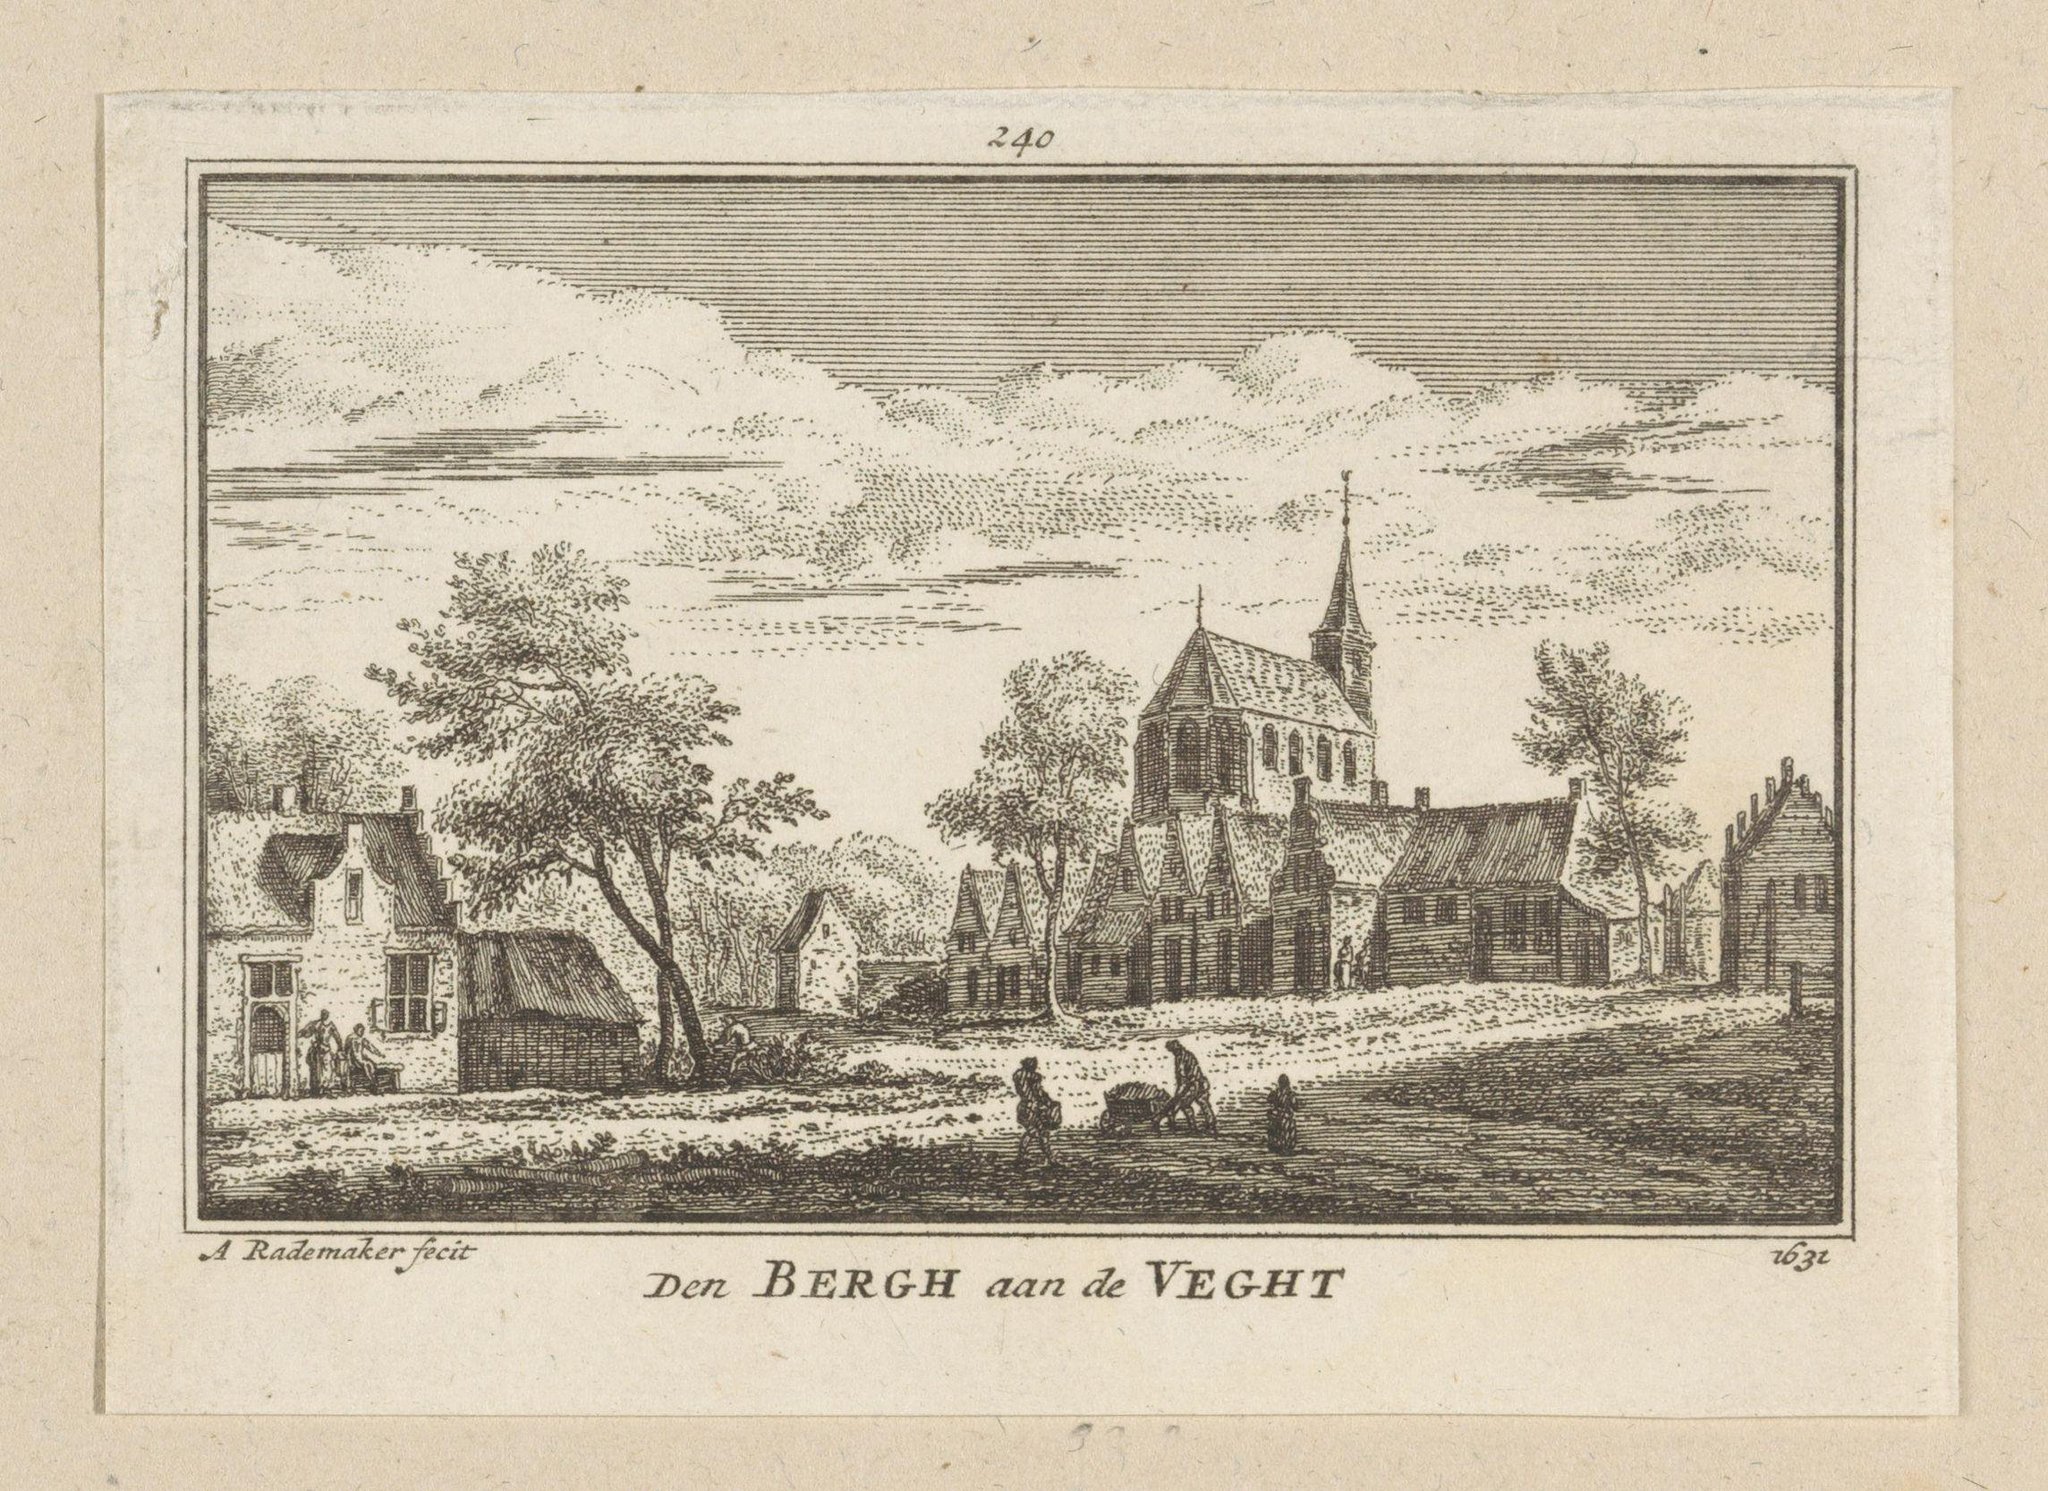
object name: print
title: Den Bergh aan de Veght 1631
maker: abraham rademaker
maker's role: draughtsman, print maker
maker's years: 1676-1735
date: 1725-1803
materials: paper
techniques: engraving, etching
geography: amsterdam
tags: church (exterior), nederhorst den berg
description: Prent ook gebruikt in: Rademaker, Abraham. Kabinet van Nederlandsche outheden en gezichten: vervat in 300 konstplaaten (…). 2 delen. Amsterdam: Willem Barents, 1725, dl. 2, ill. 240. Na 1725 is deze prent nog in verschillende heruitgaven verschenen, uitgegeven in 1727-1733, 1770-1771 en 1792-1803. Uit welke uitgave het huidige exemplaar precies komt is niet na te gaan.